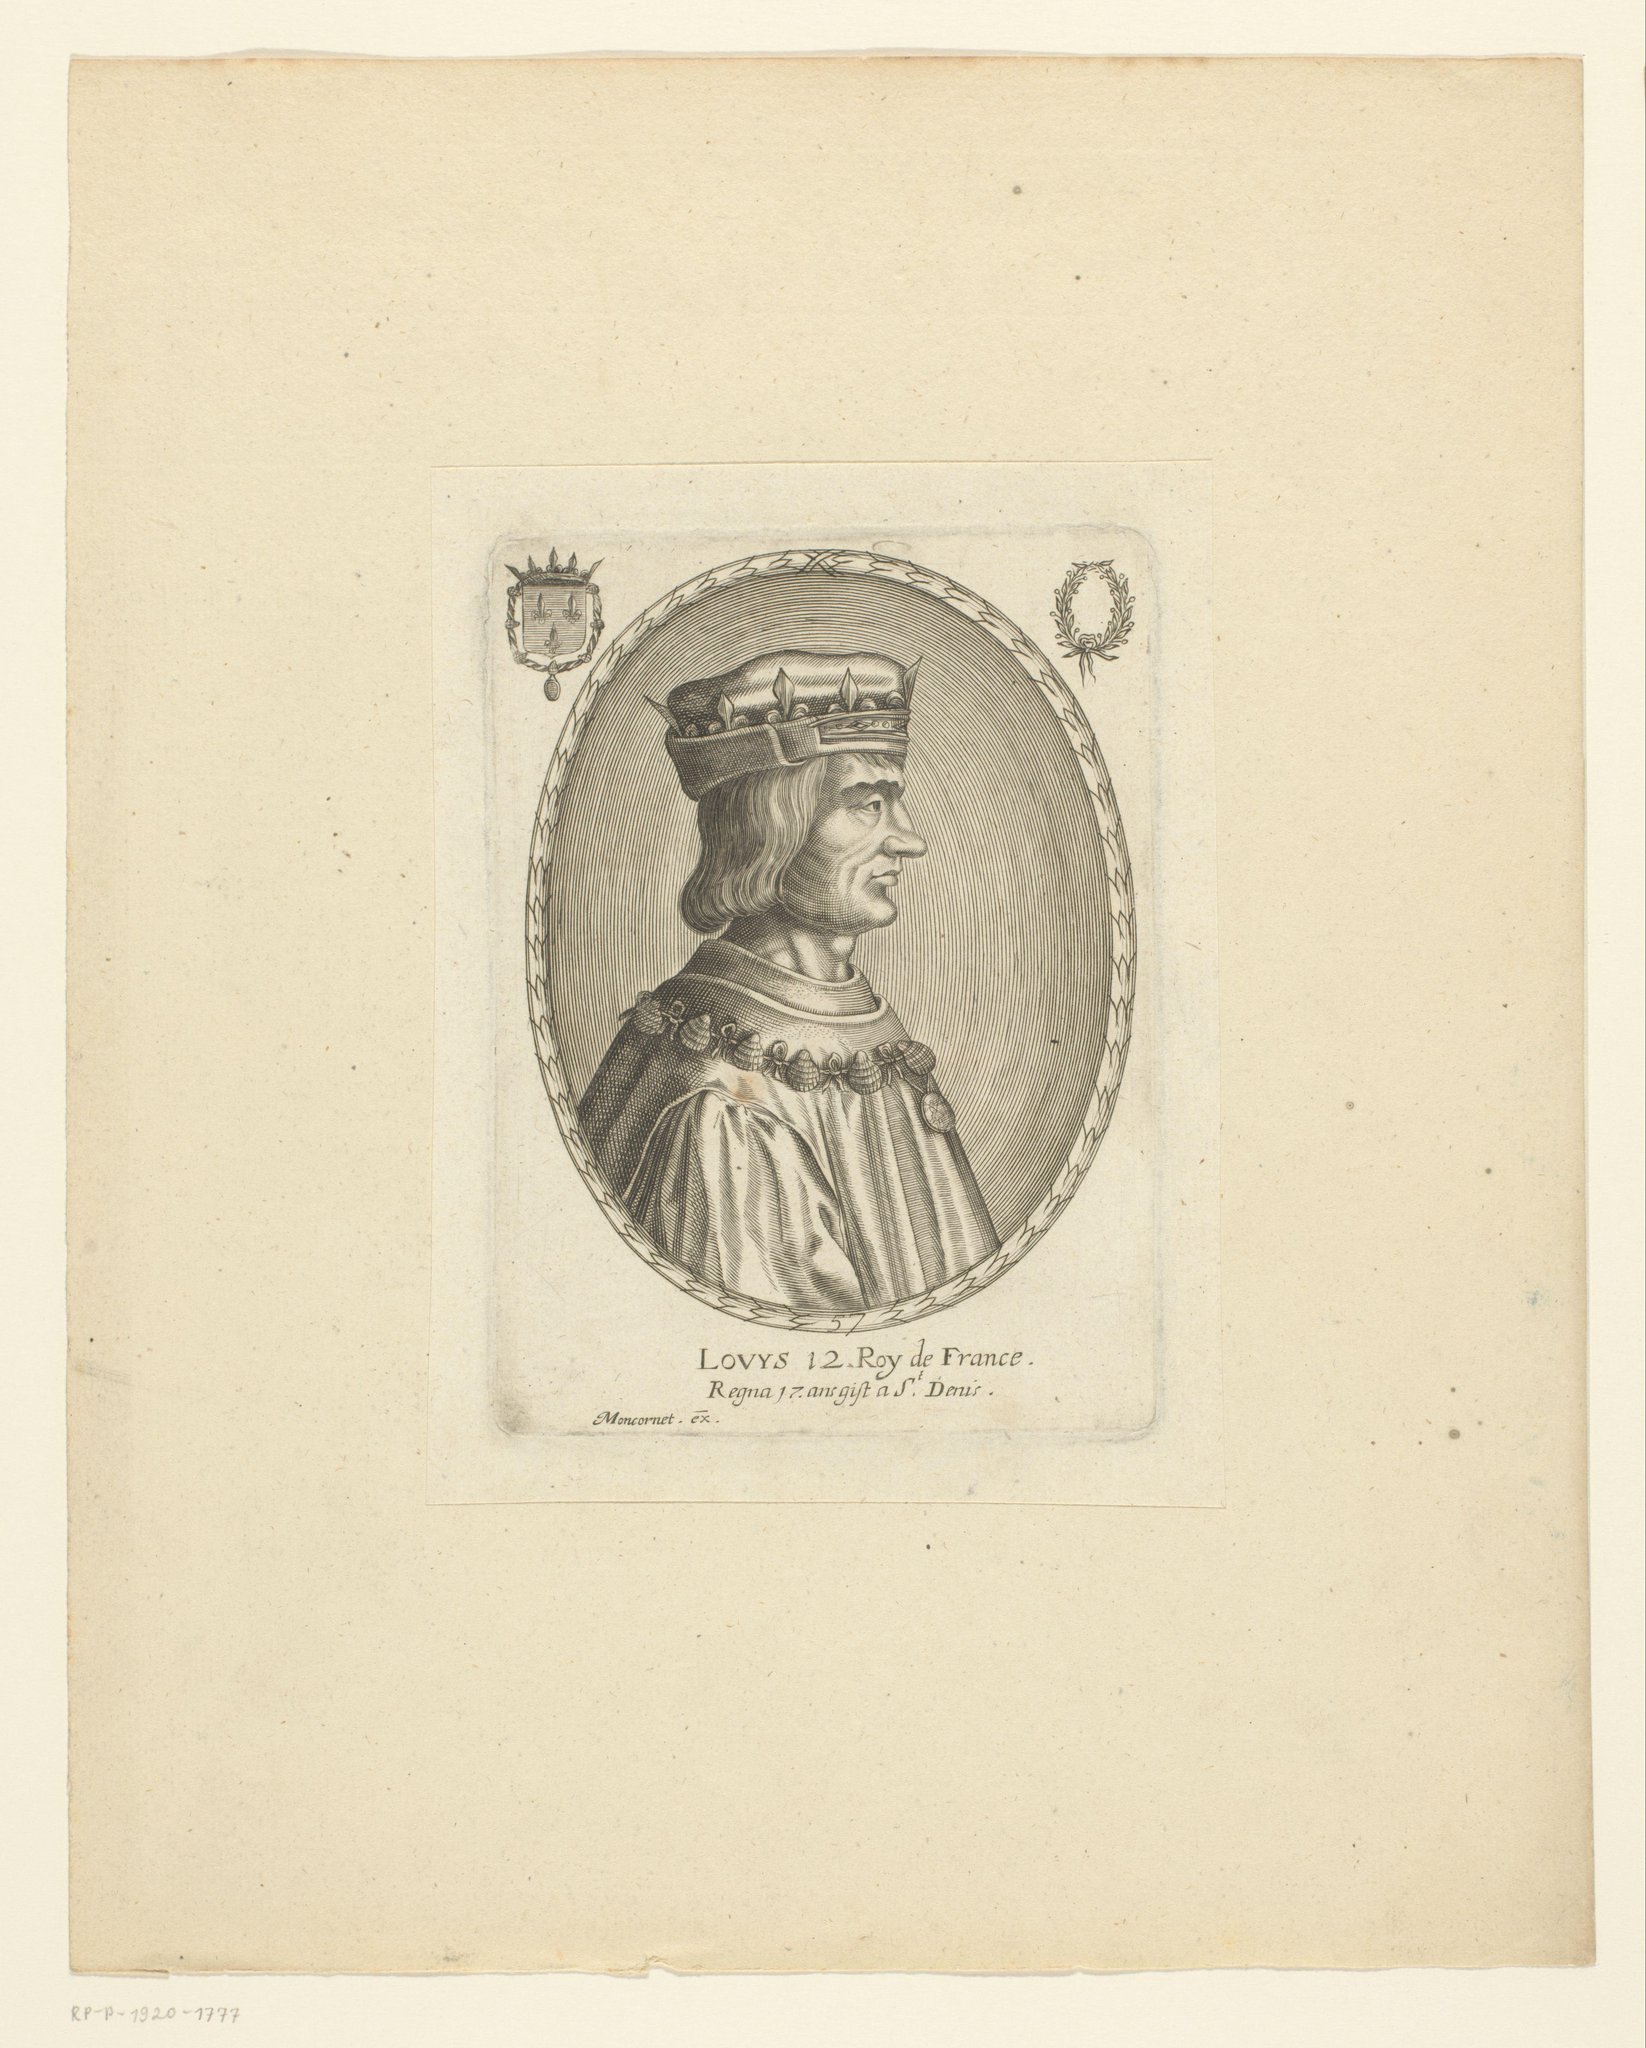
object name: print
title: Portret van Lodewijk XII van Frankrijk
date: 1610-1668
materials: paper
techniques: engraving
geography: paris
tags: paris, historical persons, king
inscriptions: collector's mark: Lugt 2228